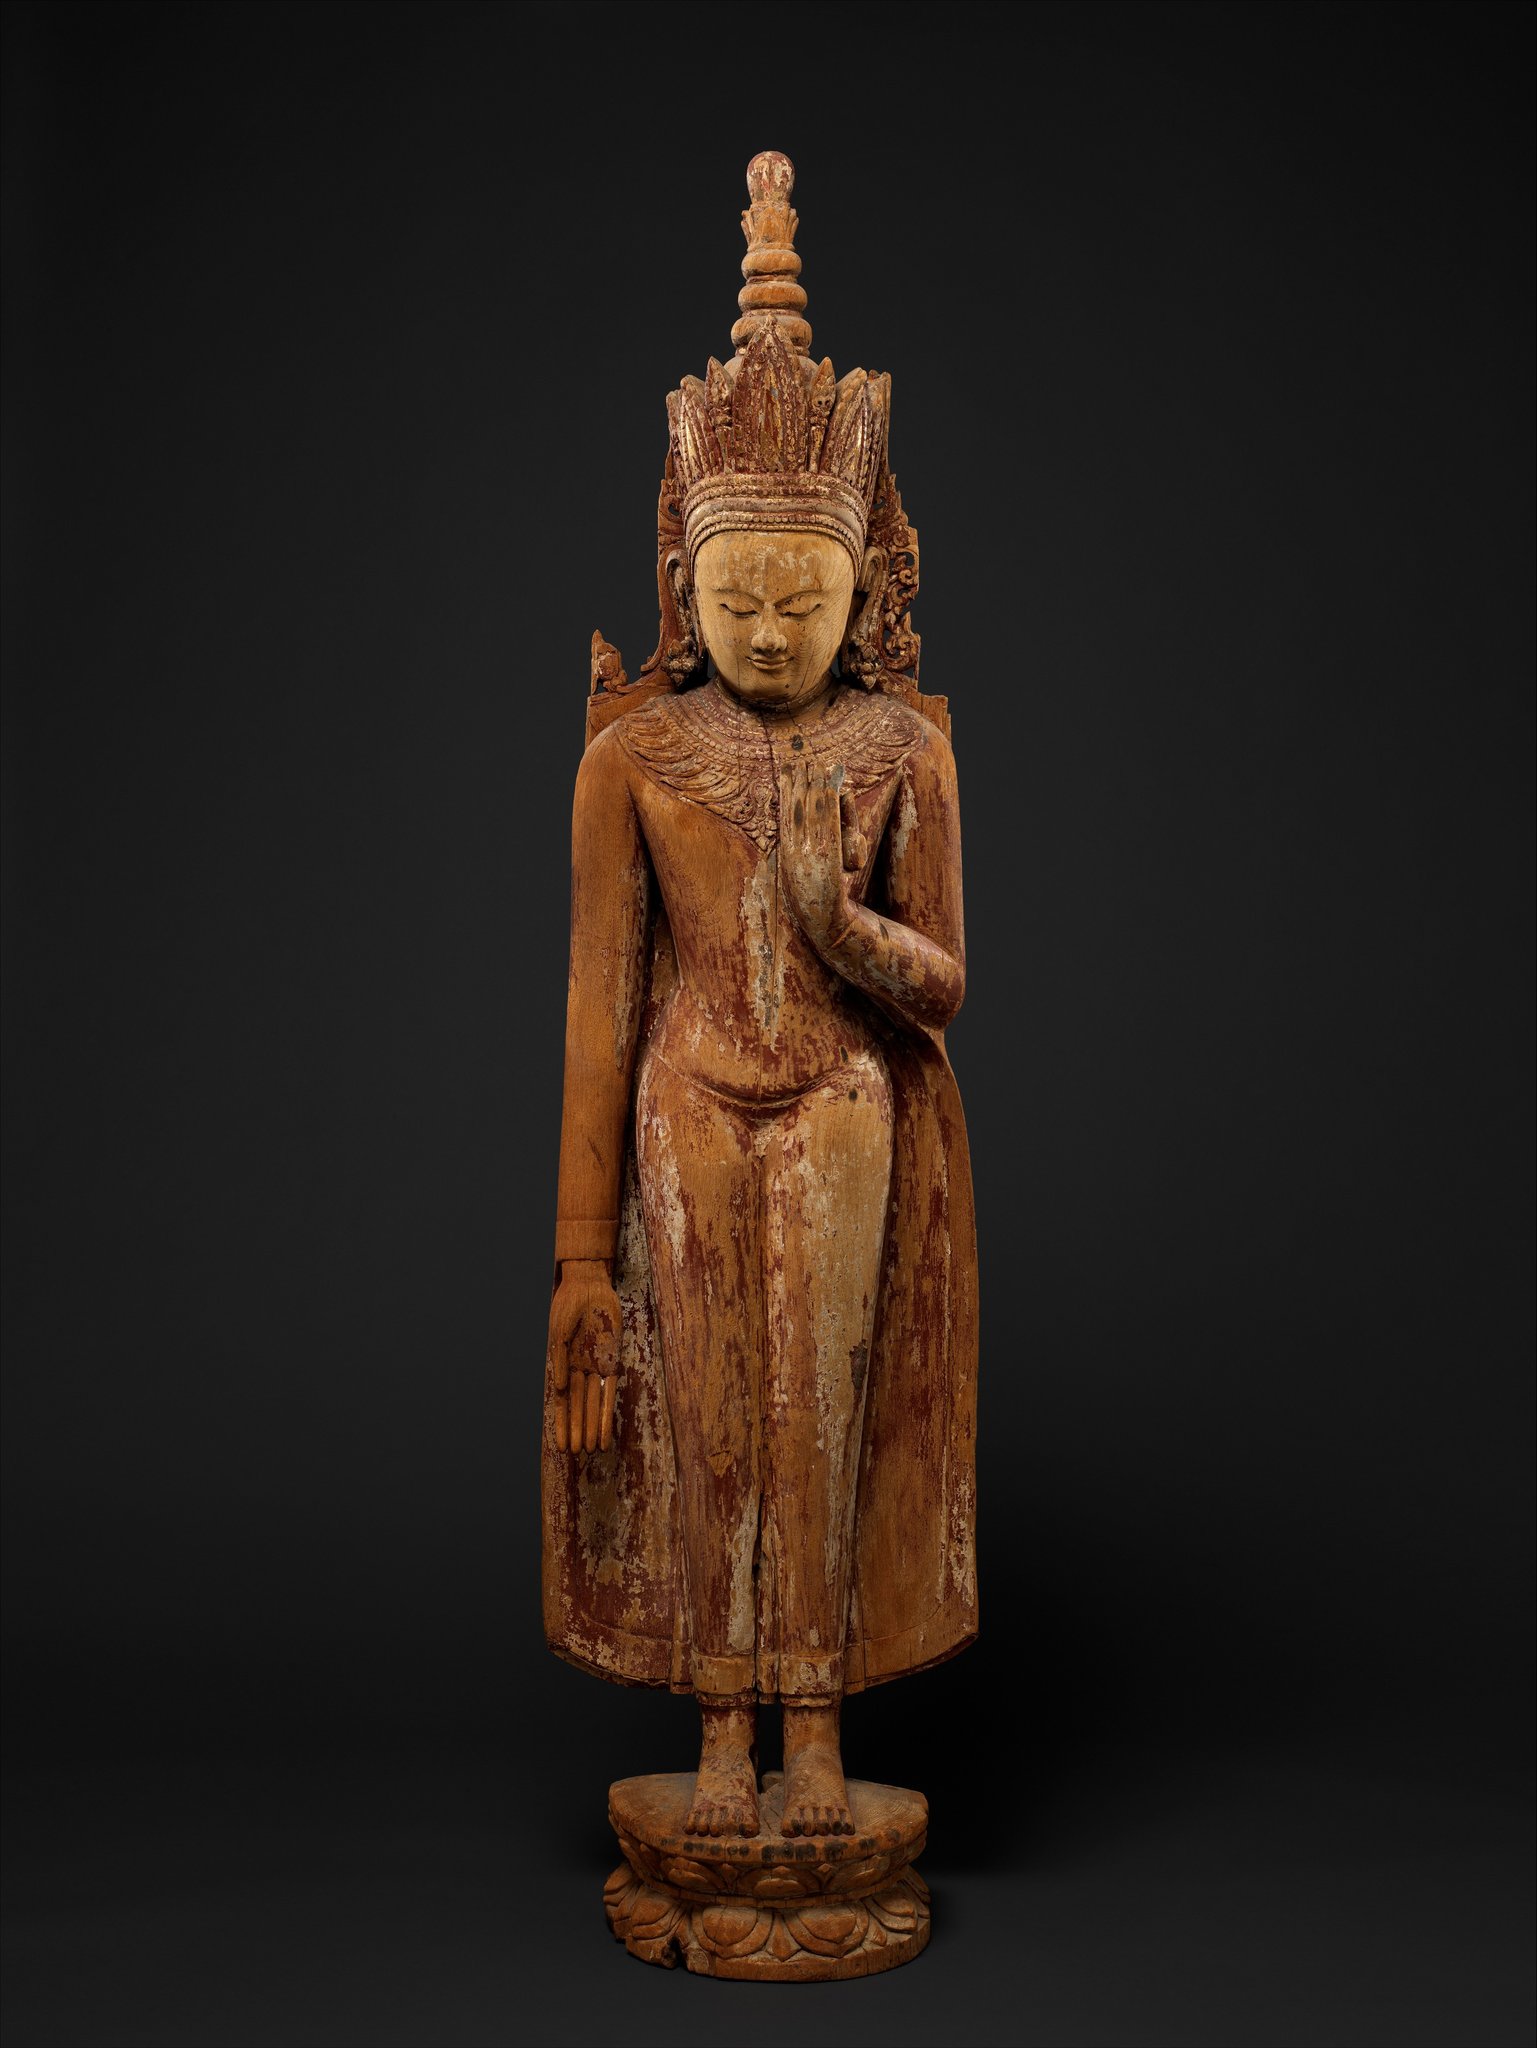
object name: statue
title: Standing Crowned and Jeweled Buddha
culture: burmese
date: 1101-1300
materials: gesso, gold leaf, lacquer, wood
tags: buddhism,buddha